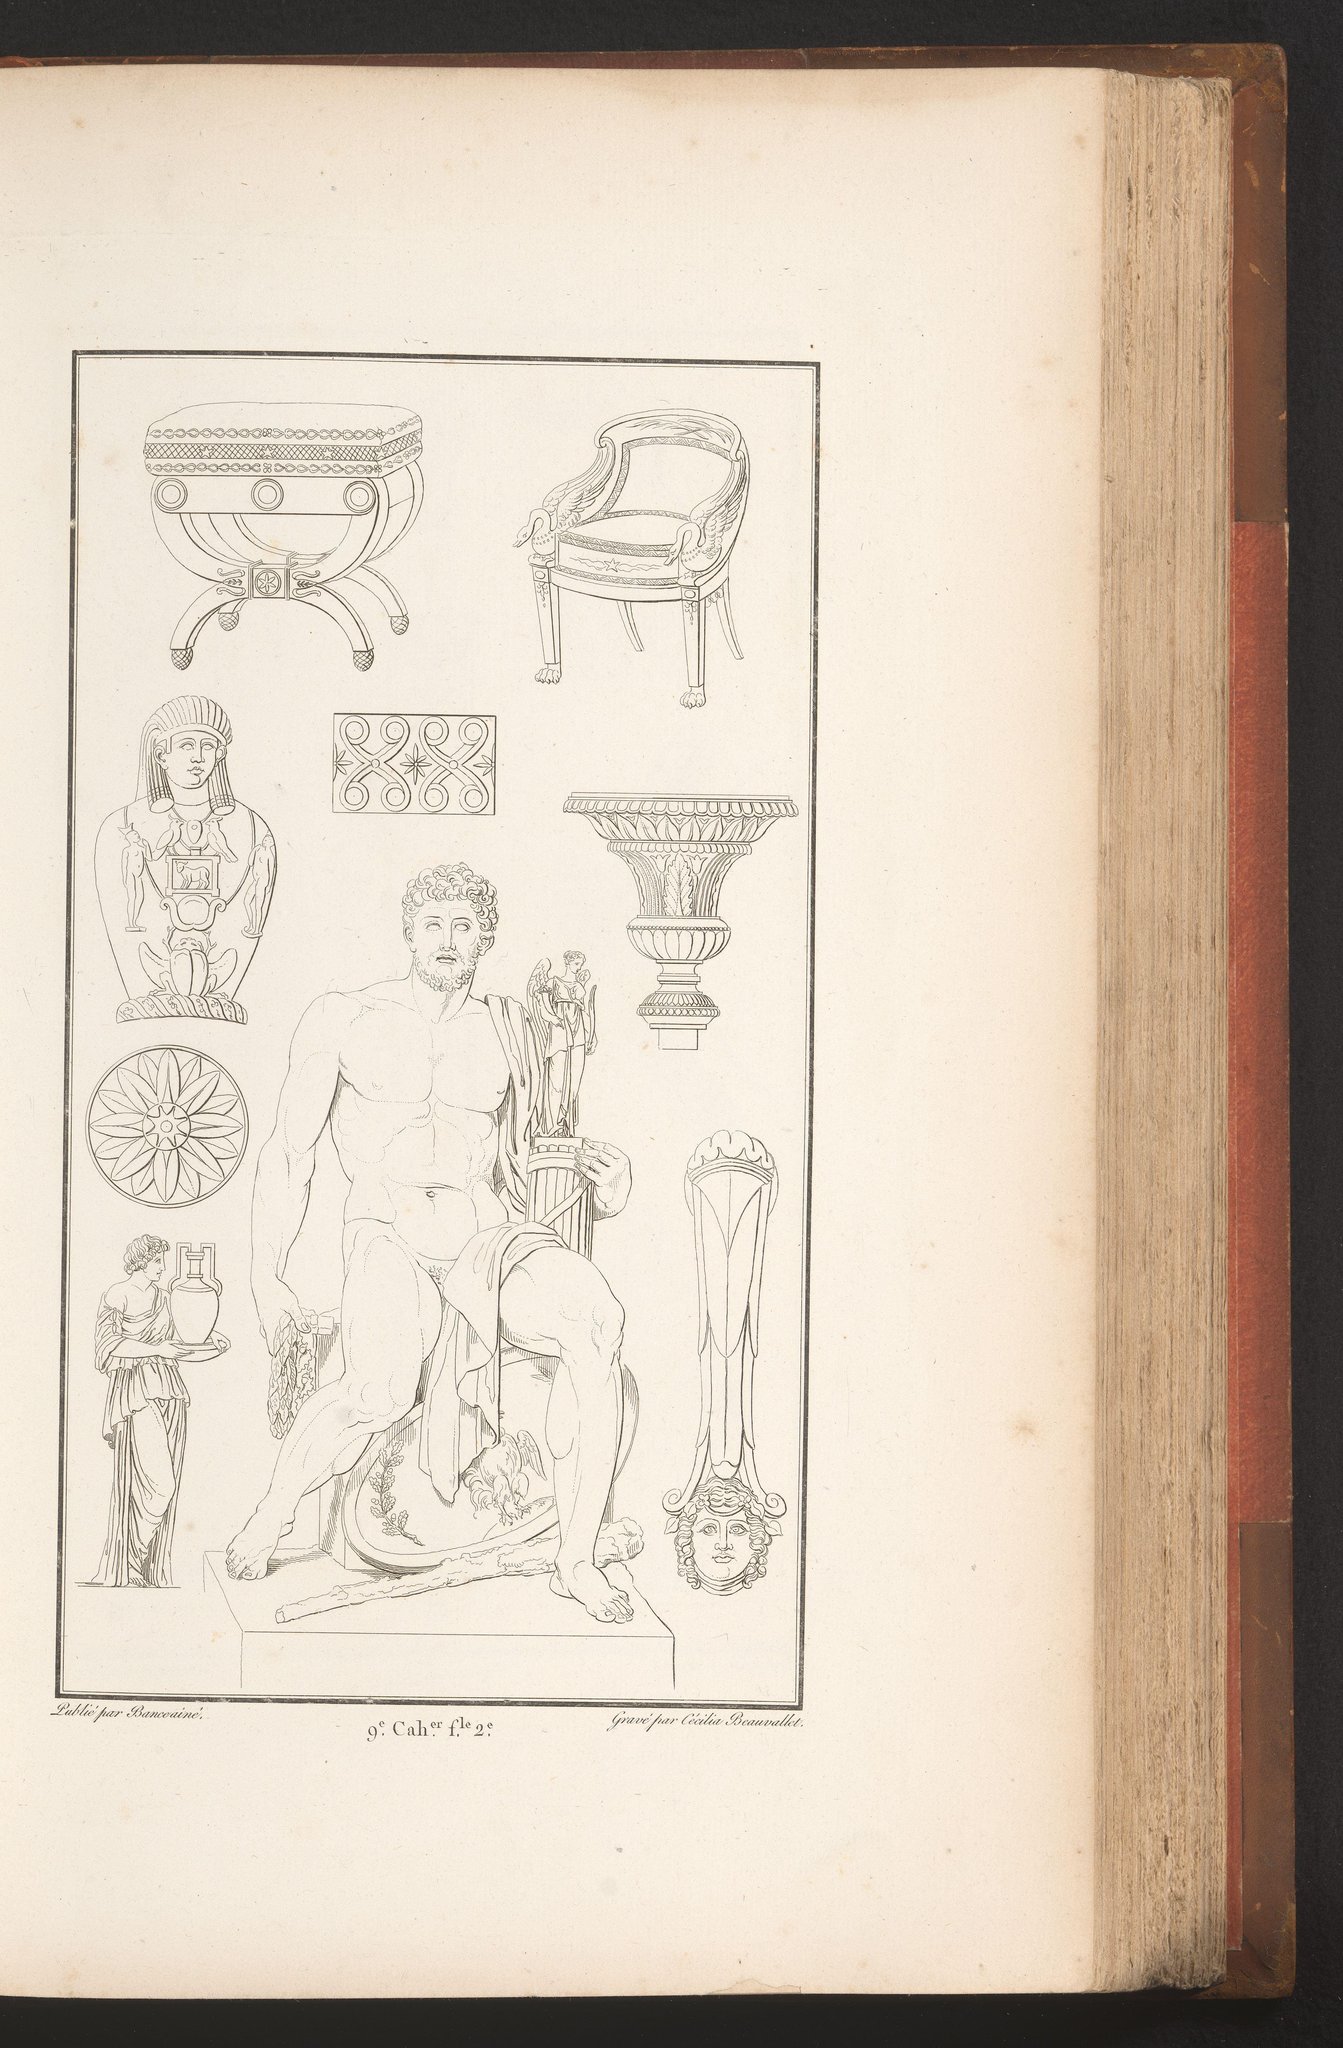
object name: ornament print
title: Diverse ornamenten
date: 1820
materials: paper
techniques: etching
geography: paris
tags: ornaments ~ art, piece of sculpture, reproduction of a piece of sculpture, specific aspects, allegorical aspects of hercules; hercules as patron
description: Ornamentprent met diverse objecten, centraal een zittende Hercules. Onderdeel (9e. Cah. f.le 2) van het prentalbum met twee series van in totaal 138 ornamentprenten door Beauvallet en Normand, 'Fragmens d'Ornemens dans le Style Antique'.